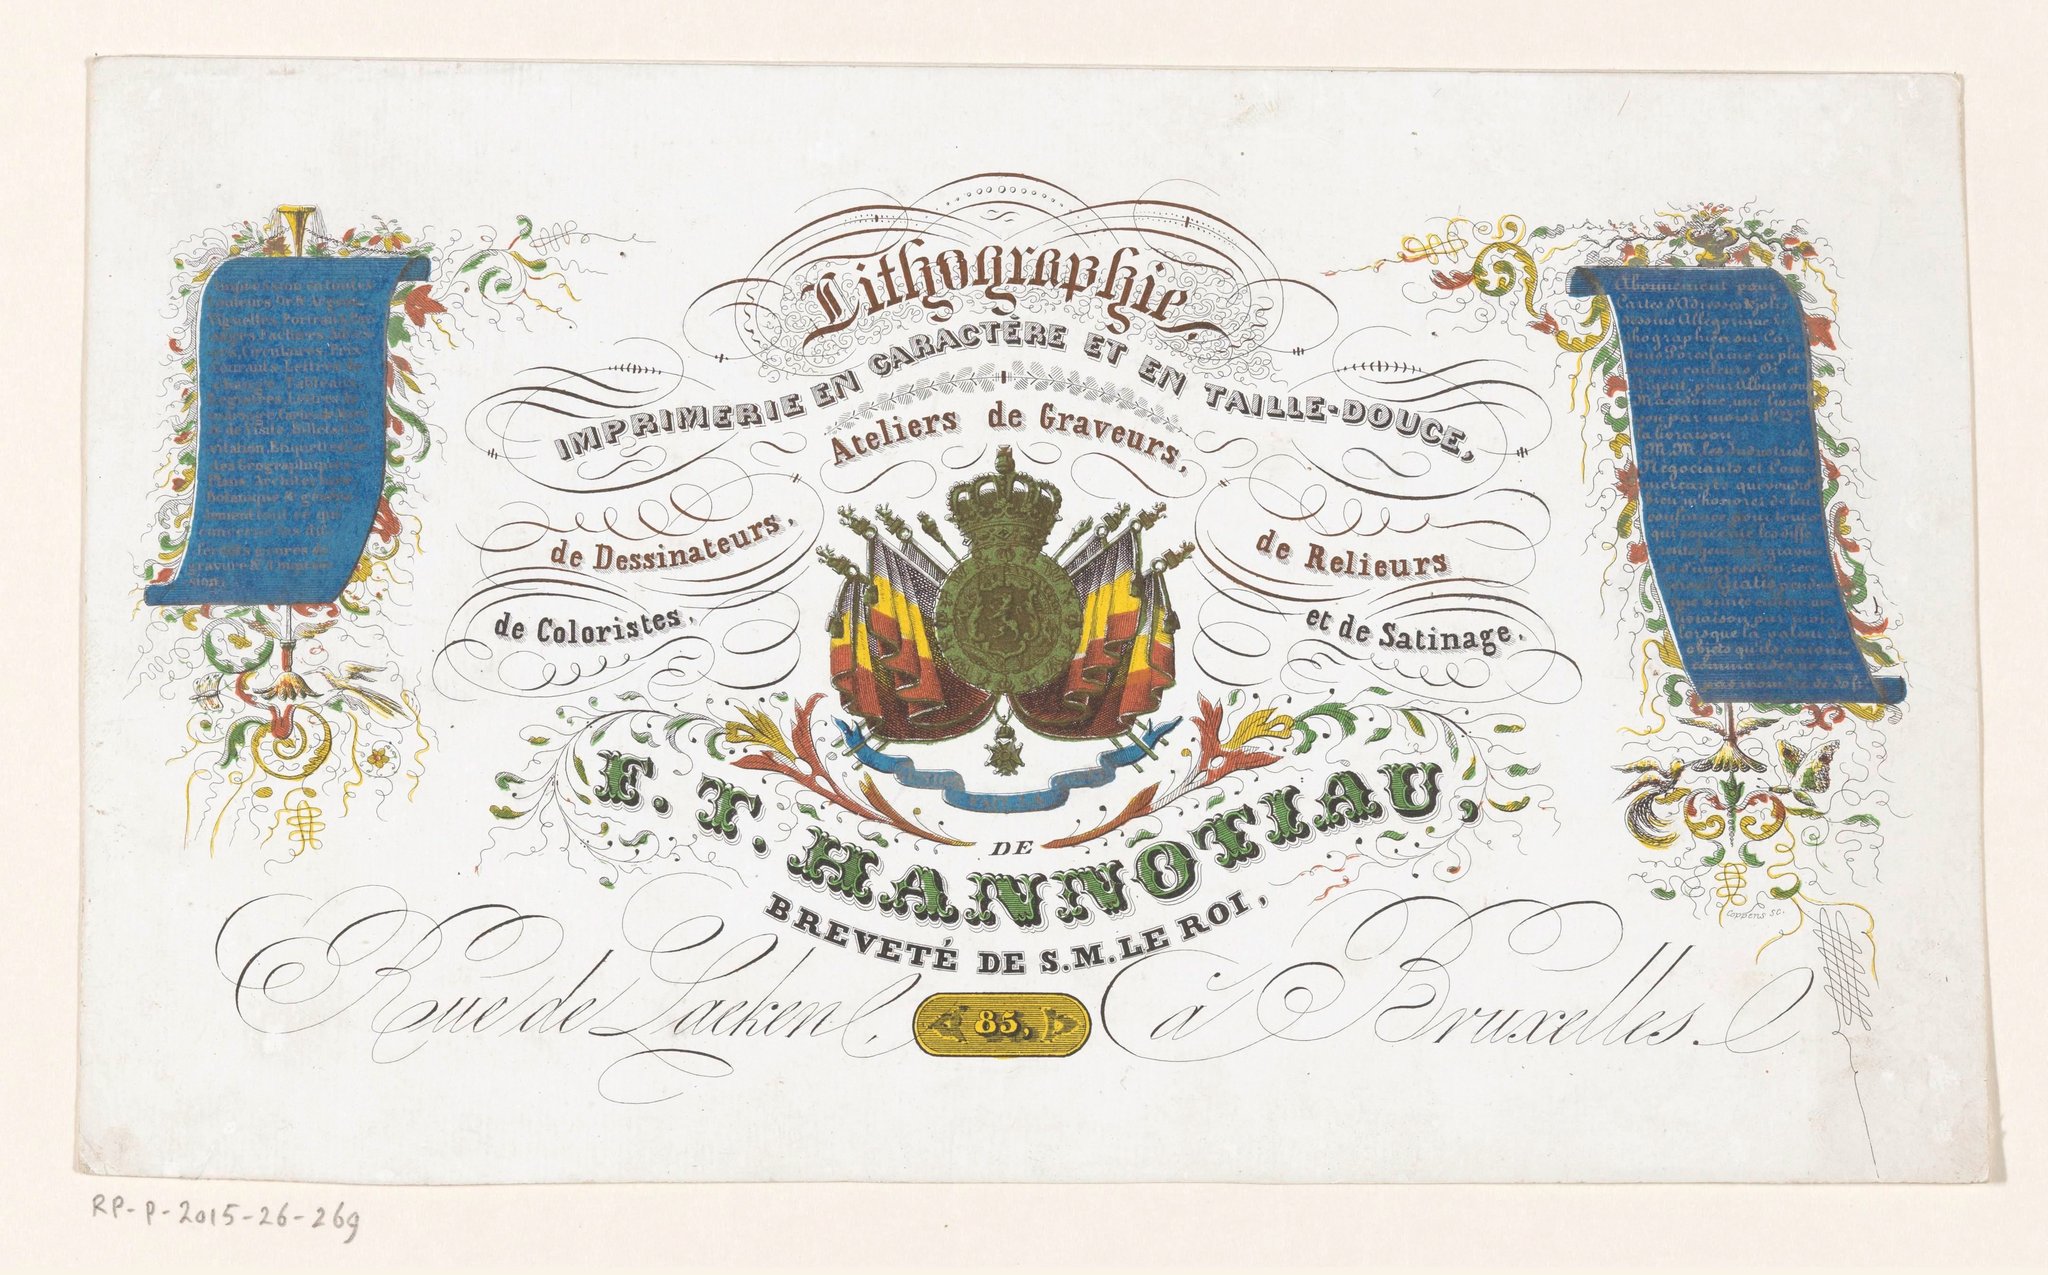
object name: visiting card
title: Visitekaartje van drukkerij Ferdinand Théodore Hannotiau te Brussel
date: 1846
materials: porcelainized cardboard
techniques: lithograph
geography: brussels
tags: lithographer, coat of arms (as symbol of the state, etc.) (+ nation; national), ribbon, scroll, banderole ~ ornament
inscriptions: collector's mark: Lugt 2228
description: Wapen van België met vlaggen, devies en Leopoldsorde. Op twee banderollen staat een overzicht van de producten die bij Hannotiau zijn te verkrijgen.